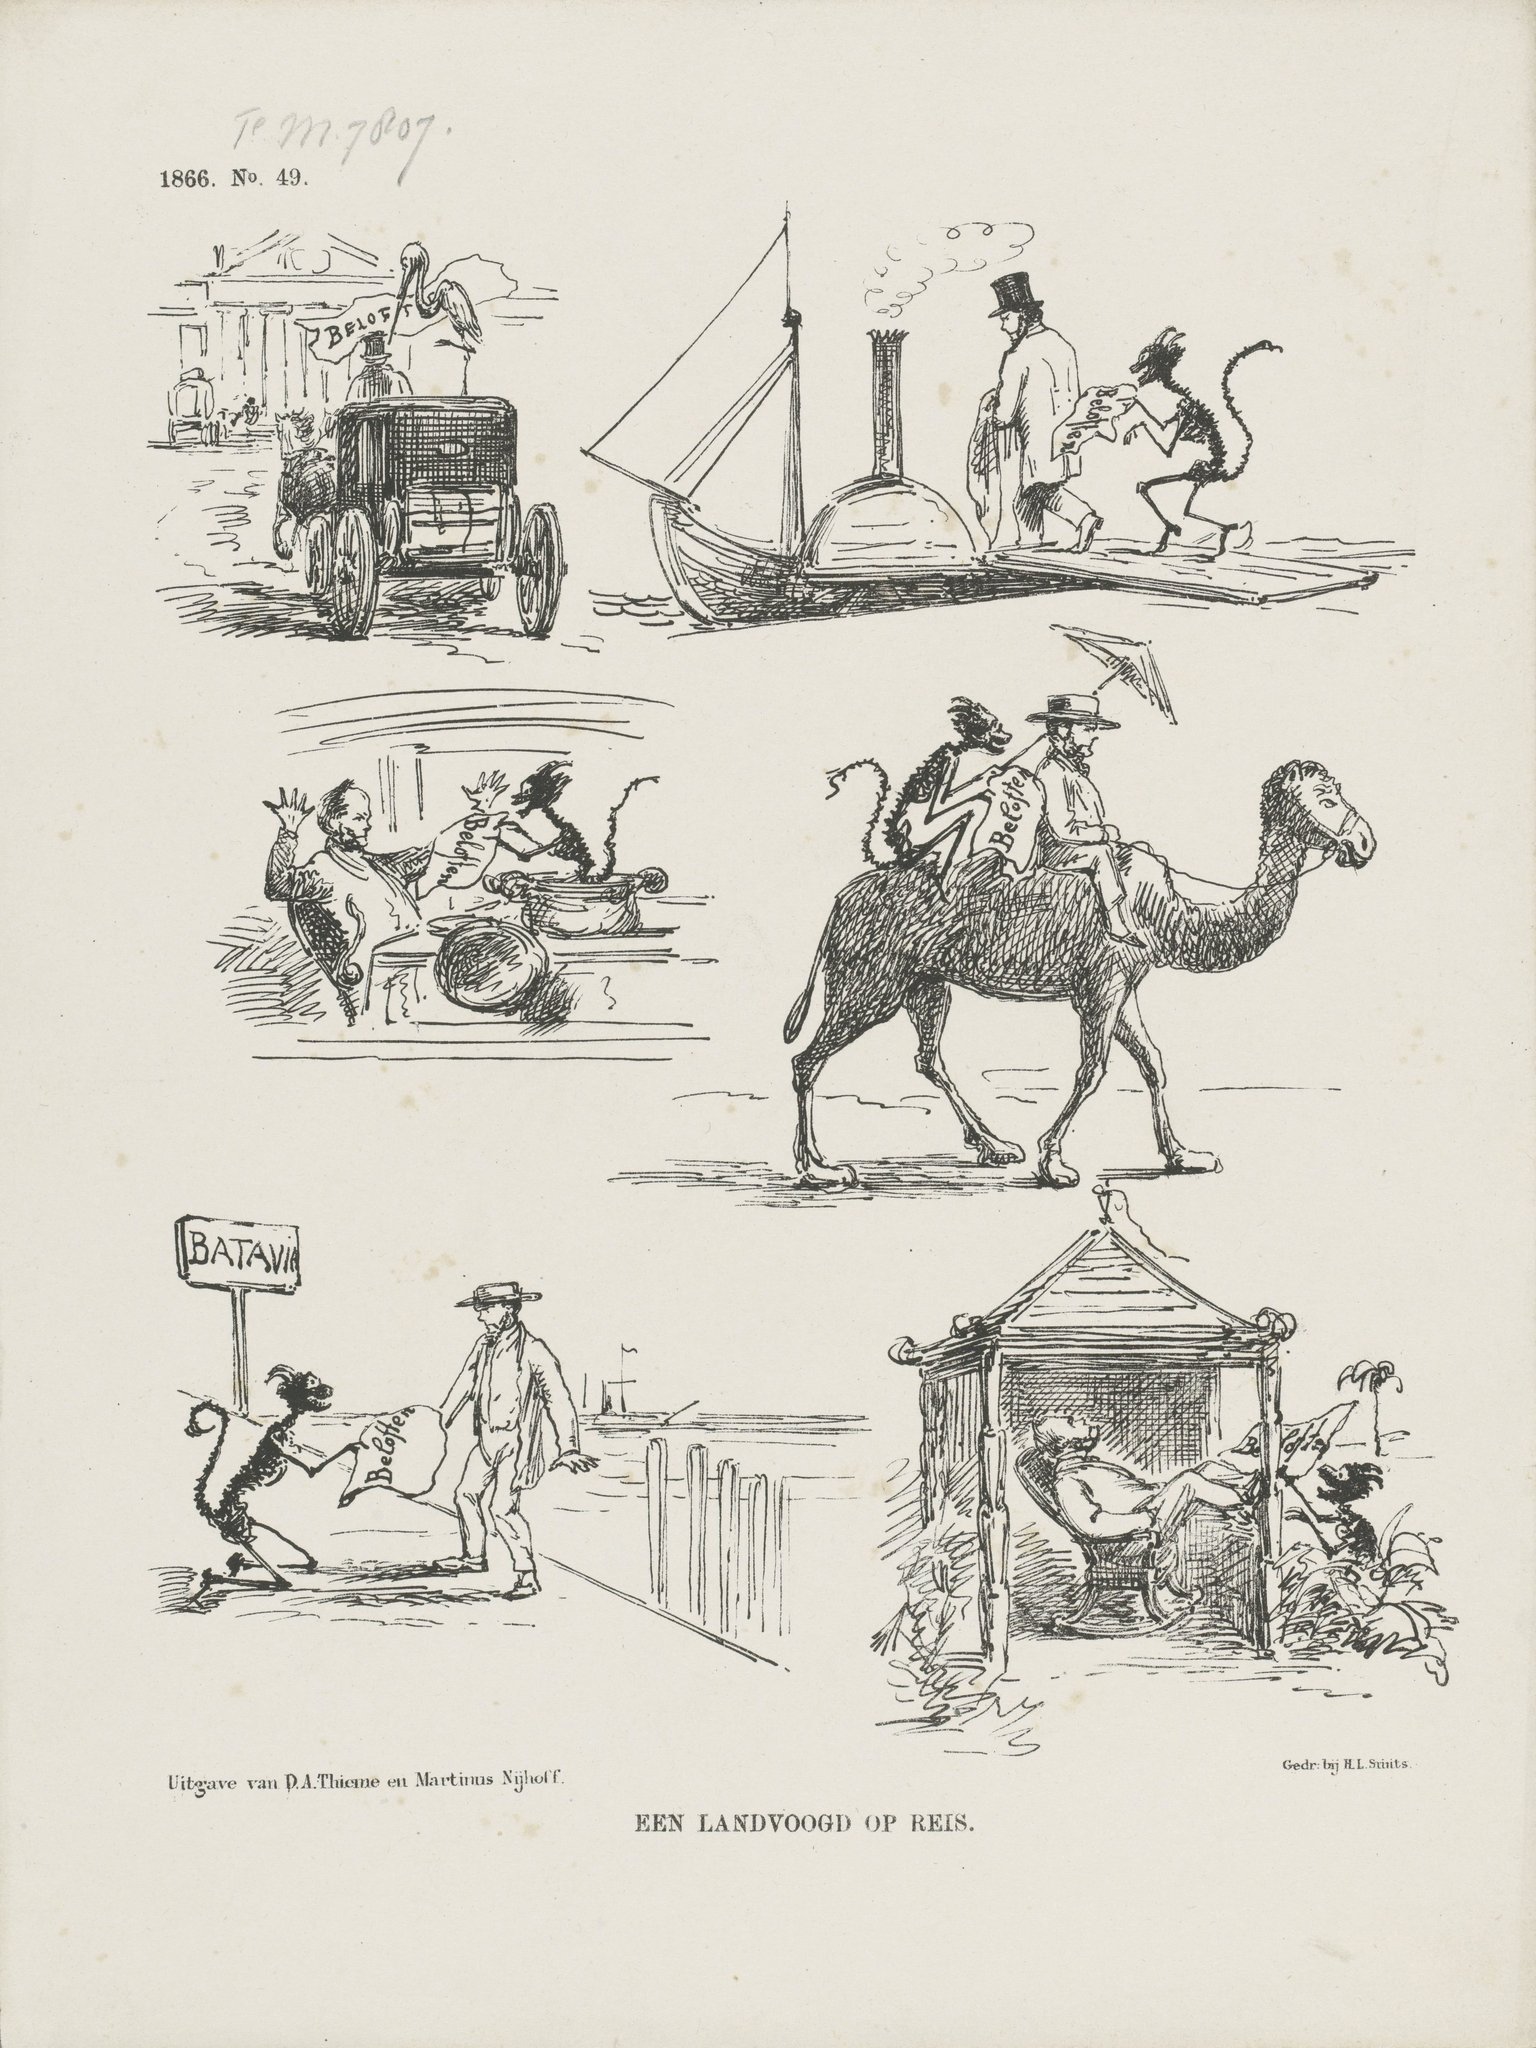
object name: print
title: Spotprent op gouverneur-generaal Mijer, 1866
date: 1866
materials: paper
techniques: lithograph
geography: netherlands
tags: 'en route', traveller under way, dutch east indies, the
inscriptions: collector's mark: Lugt 2228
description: Spotprent op de reis van gouverneur-generaal Mijer naar Indië, de gehele tijd vergezeld door een duiveltje. Plaat verschenen bij het weekblad De Nederlandsche Spectator, nr. 49, 8 december 1866.